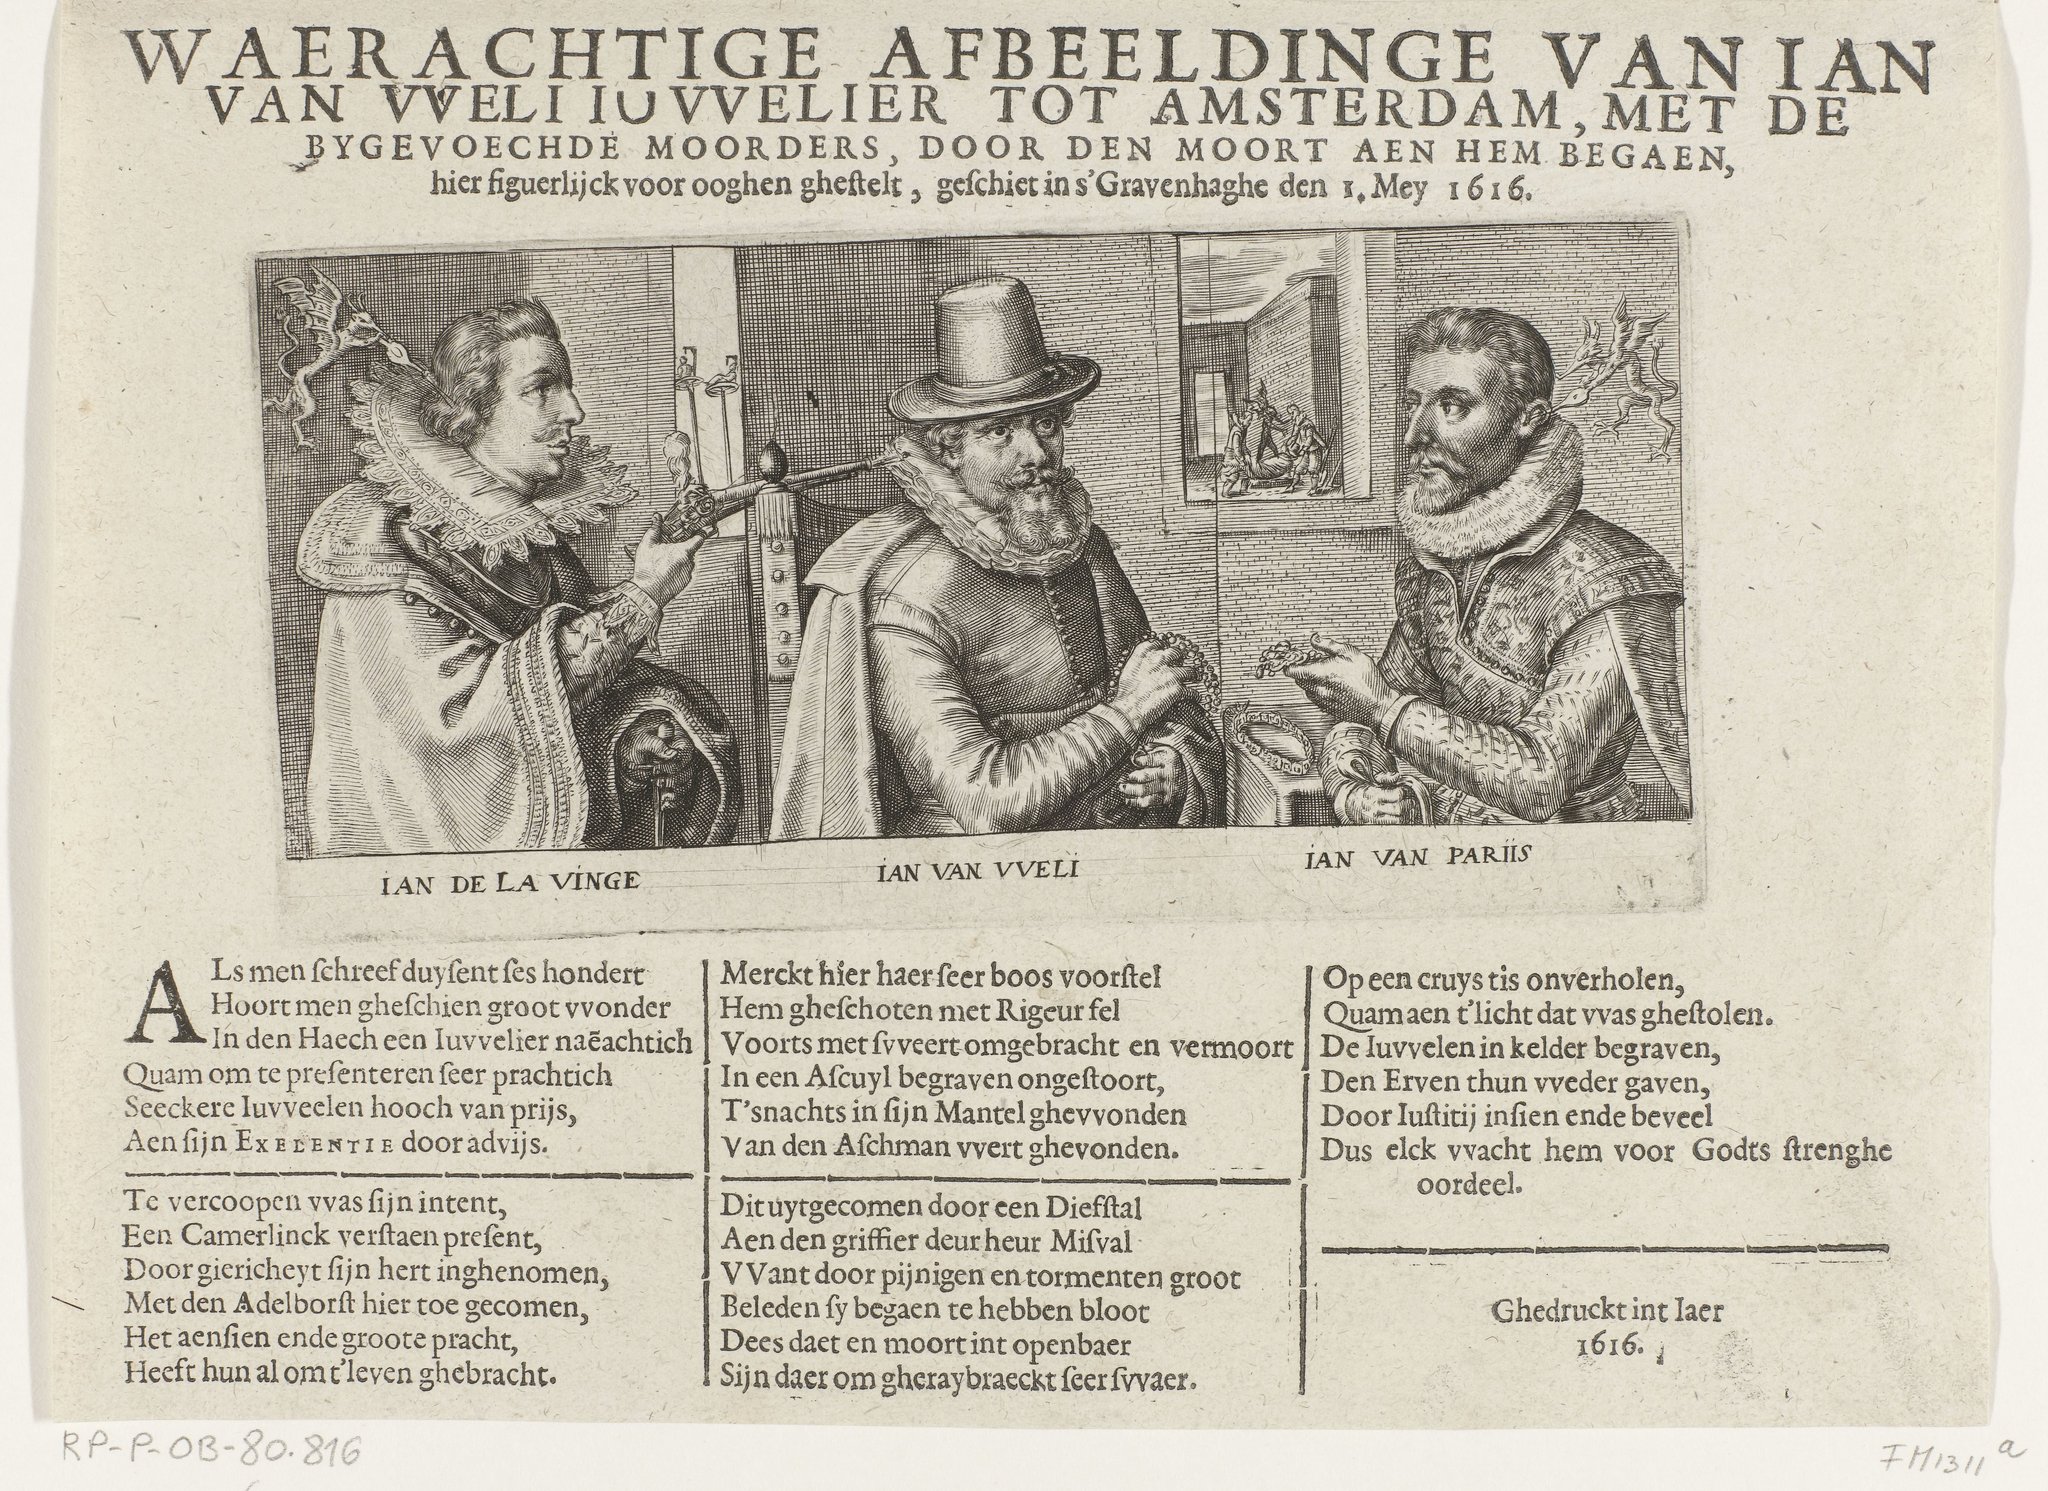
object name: print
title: Moord op Jan van Wely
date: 1616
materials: paper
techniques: engraving, letterpress printing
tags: maurice (prince of orange), murder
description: De roofmoord op de door Maurits naar Den Haag ontboden Amsterdamse juwelier Jan van Wely, te Den Haag op 1 mei 1616. De moord met links Jan de la Vigne en rechts Jan van Parijs. Beiden worden door een duiveltje met een blaasbalg bij hun oor aangezet tot de moord. Op de achtergrond (zeer klein) het vinden van het lijk van de juwelier en de de lichamen van de geradbraakte moordenaars tentoongesteld op staken. Gedrukt op een blad met bovenaan de titel en onderaan 5 verzen van 6 regels in het Nederlands.